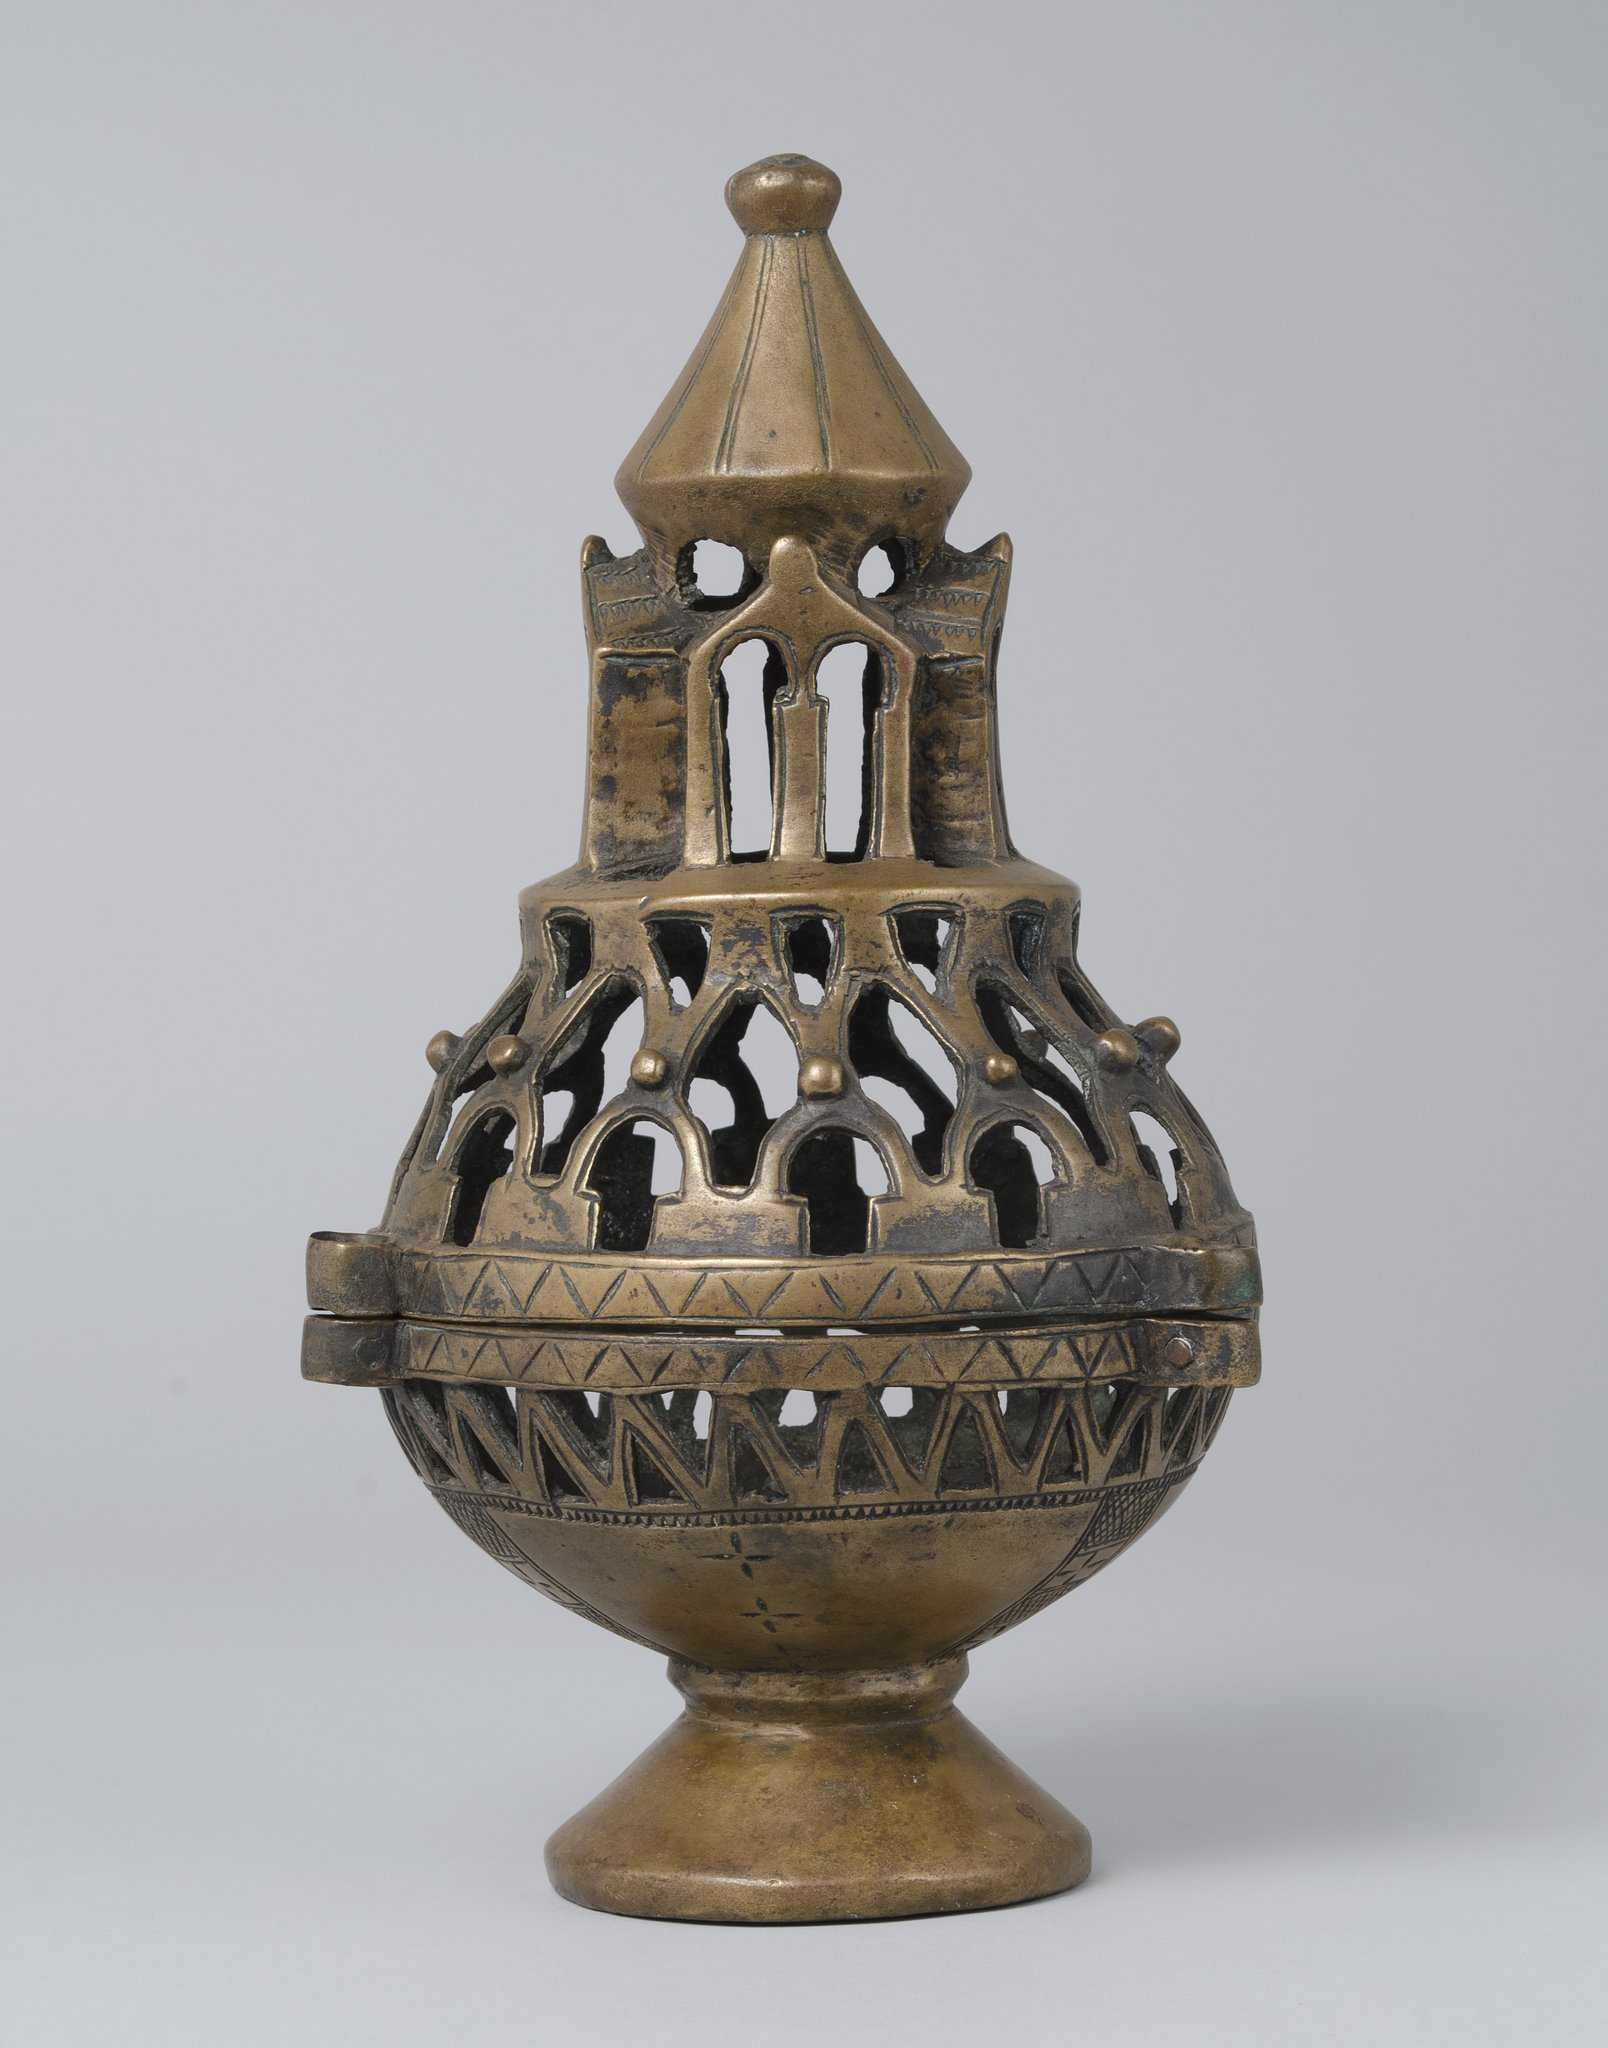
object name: censer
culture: german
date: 1201-1300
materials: copper alloy